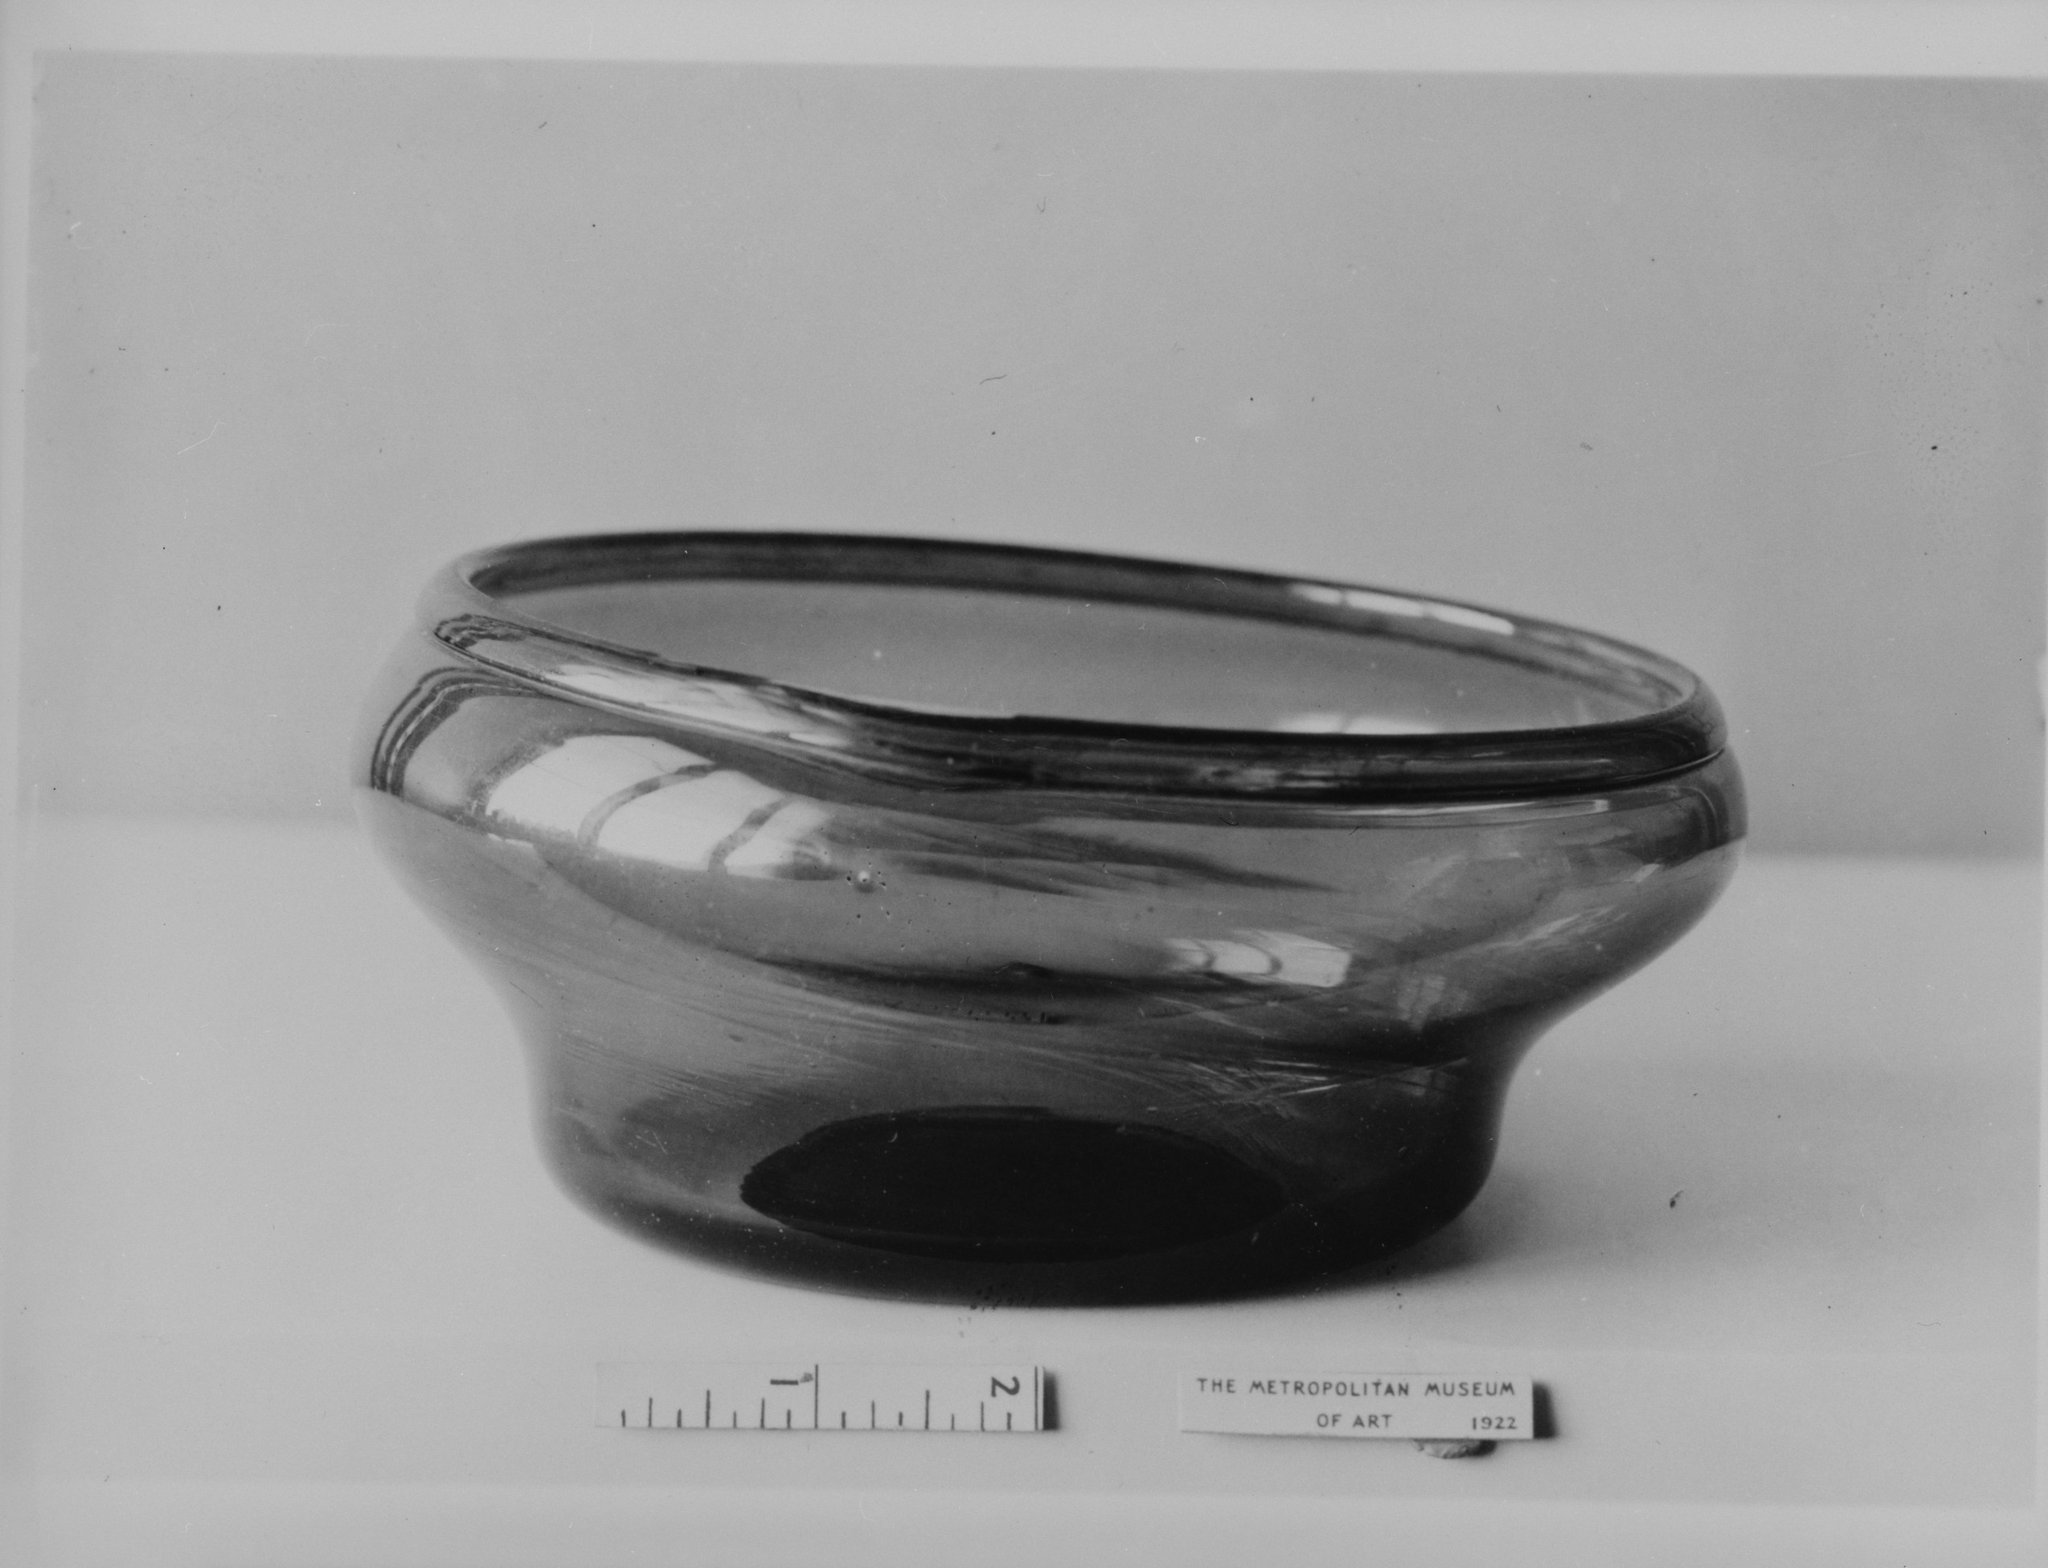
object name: bowl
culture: american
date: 1801-1900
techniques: glassblowing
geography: united states